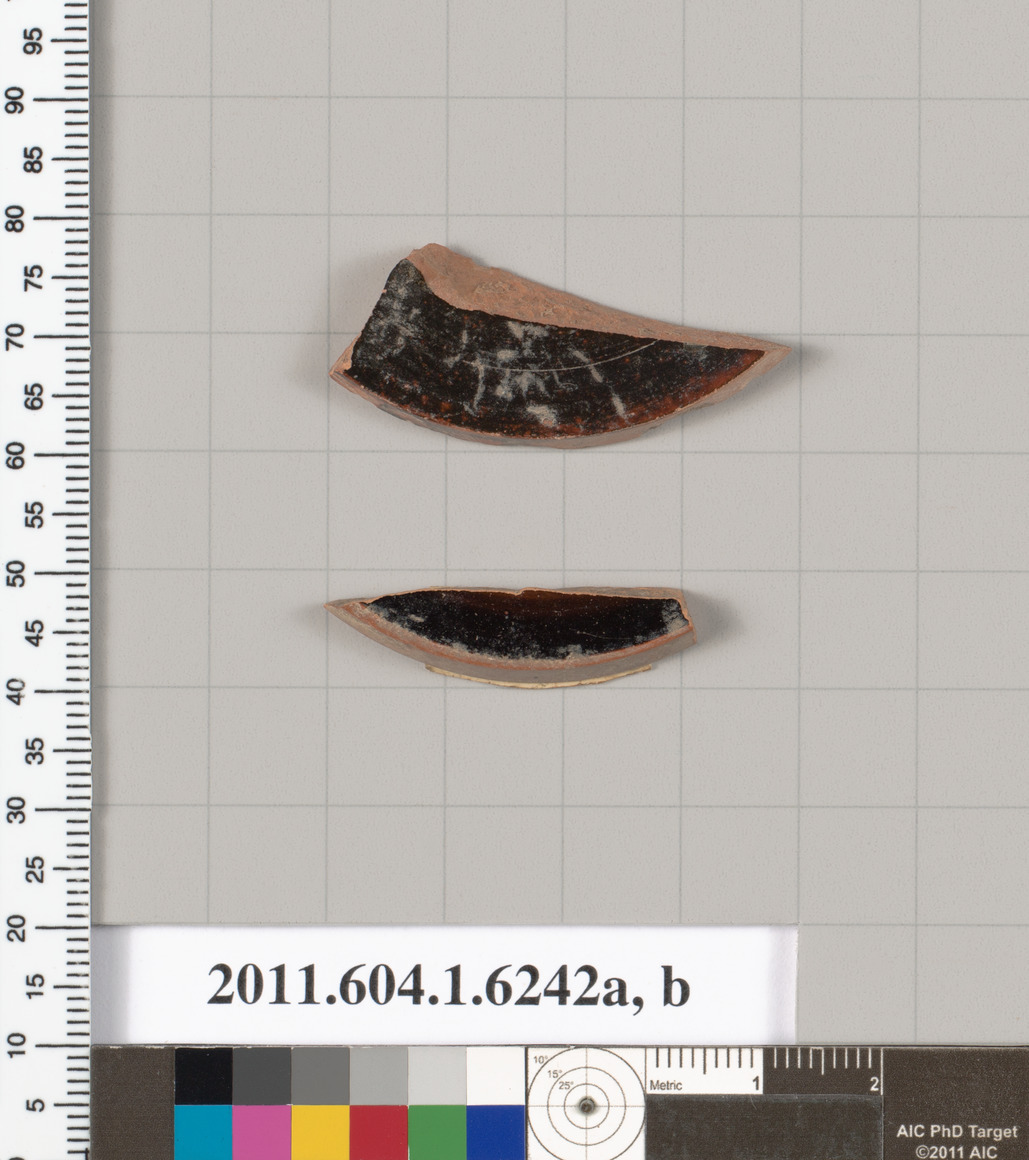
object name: kylix fragment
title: Terracotta fragments of kylikes (drinking cups)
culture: greek, attic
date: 534-468 BCE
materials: terracotta